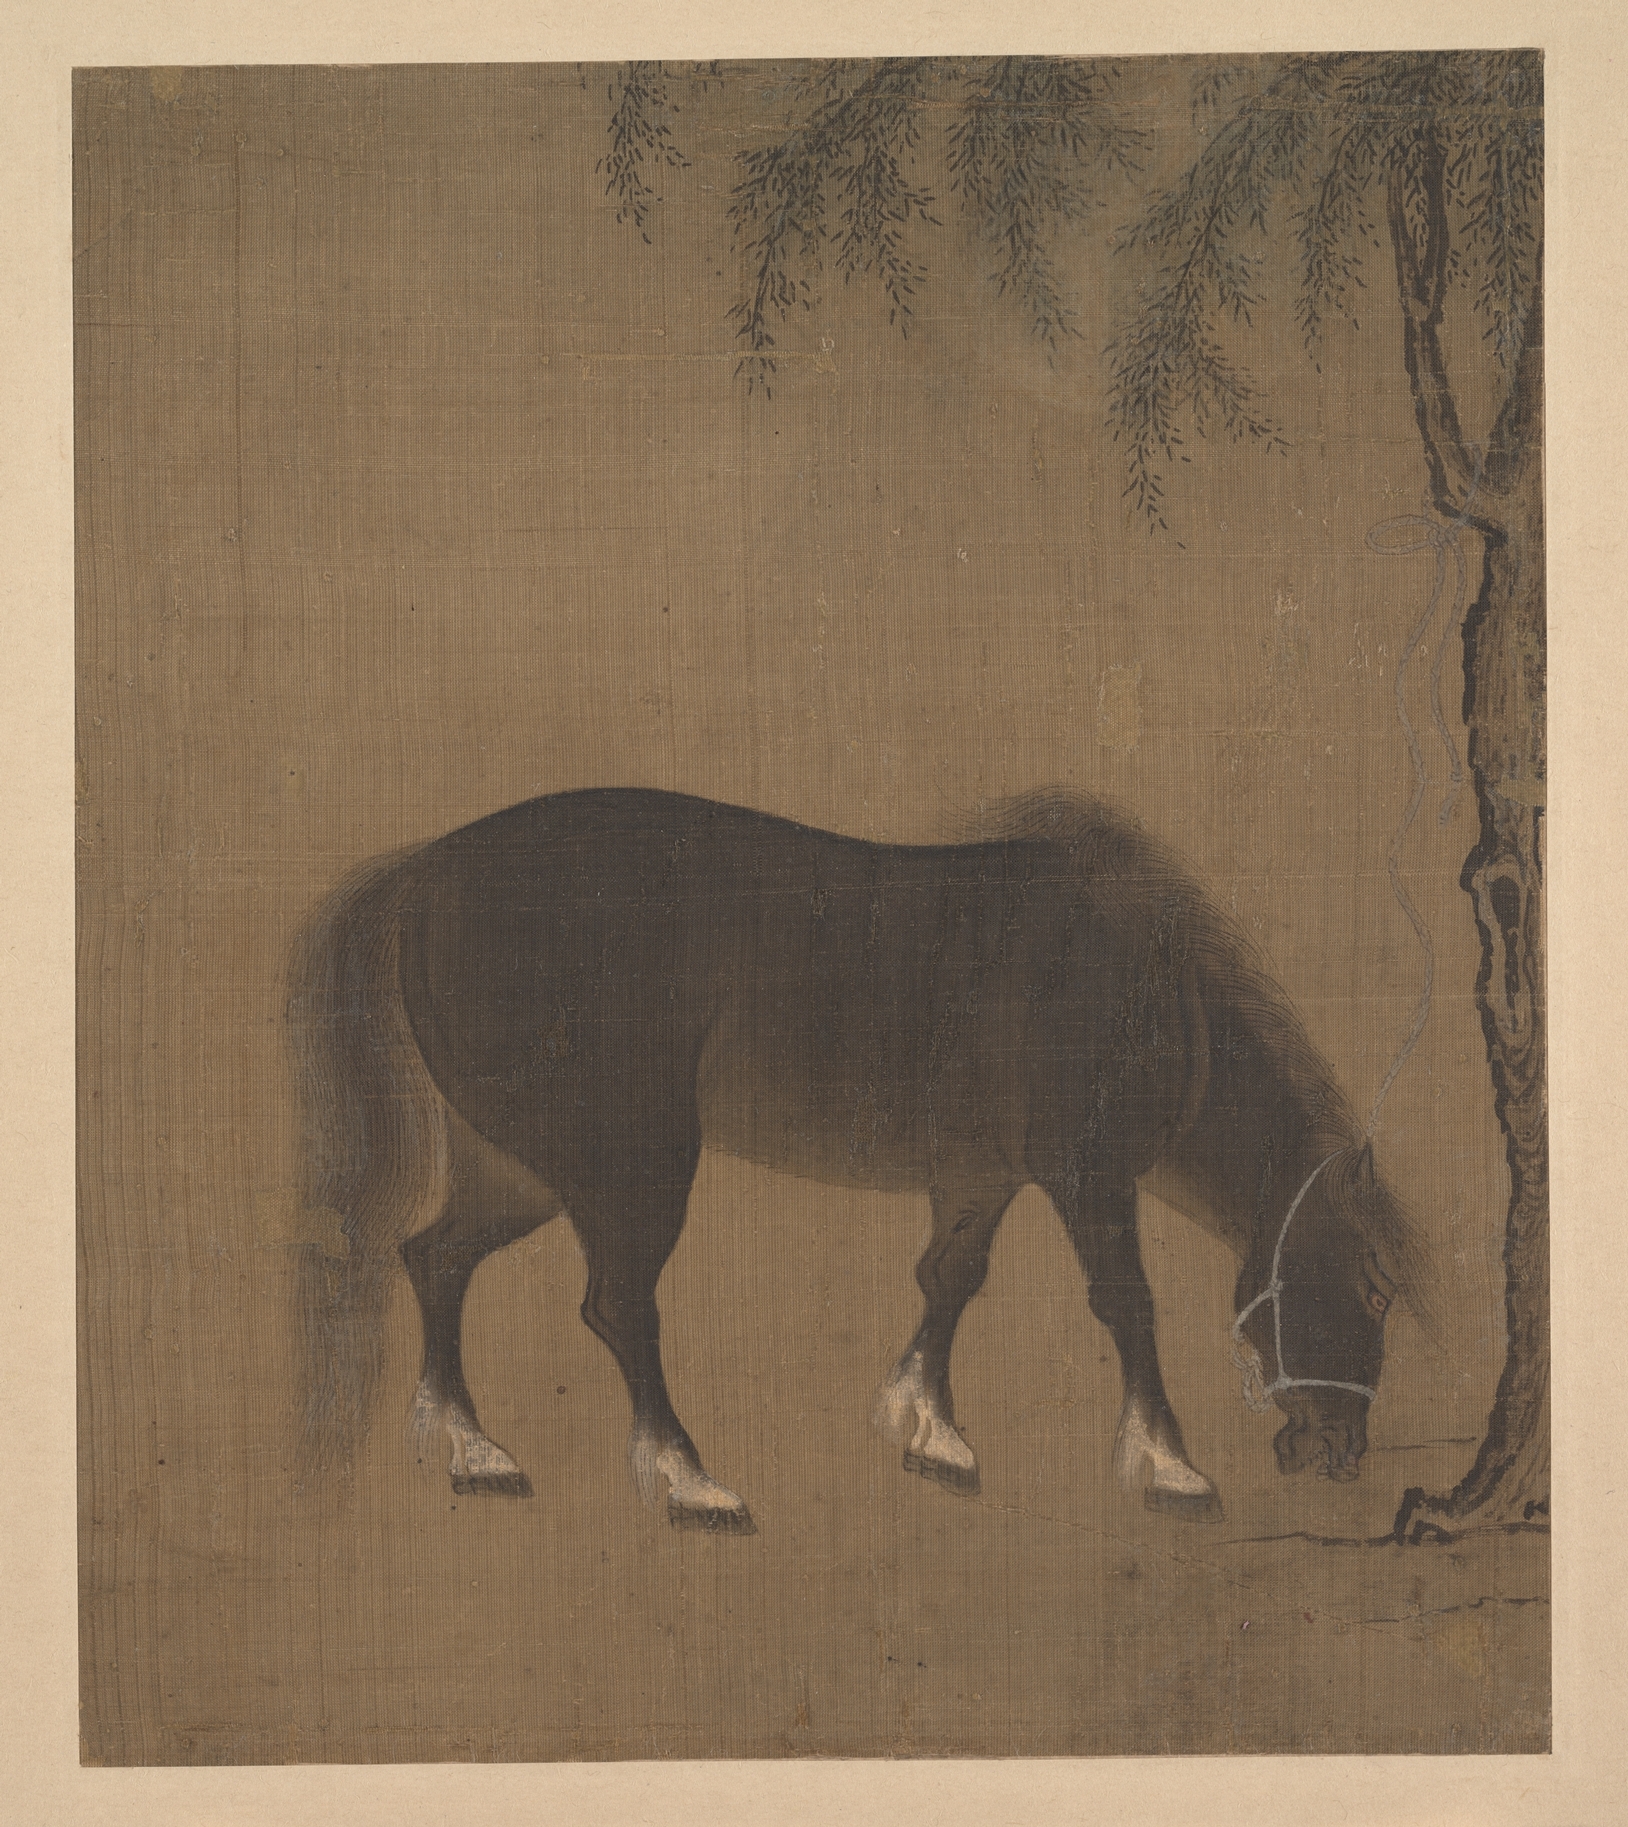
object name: album leaf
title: Horse and Willow Tree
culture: chinese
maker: unidentified artist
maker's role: artist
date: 1401-1433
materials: ink, silk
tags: horses